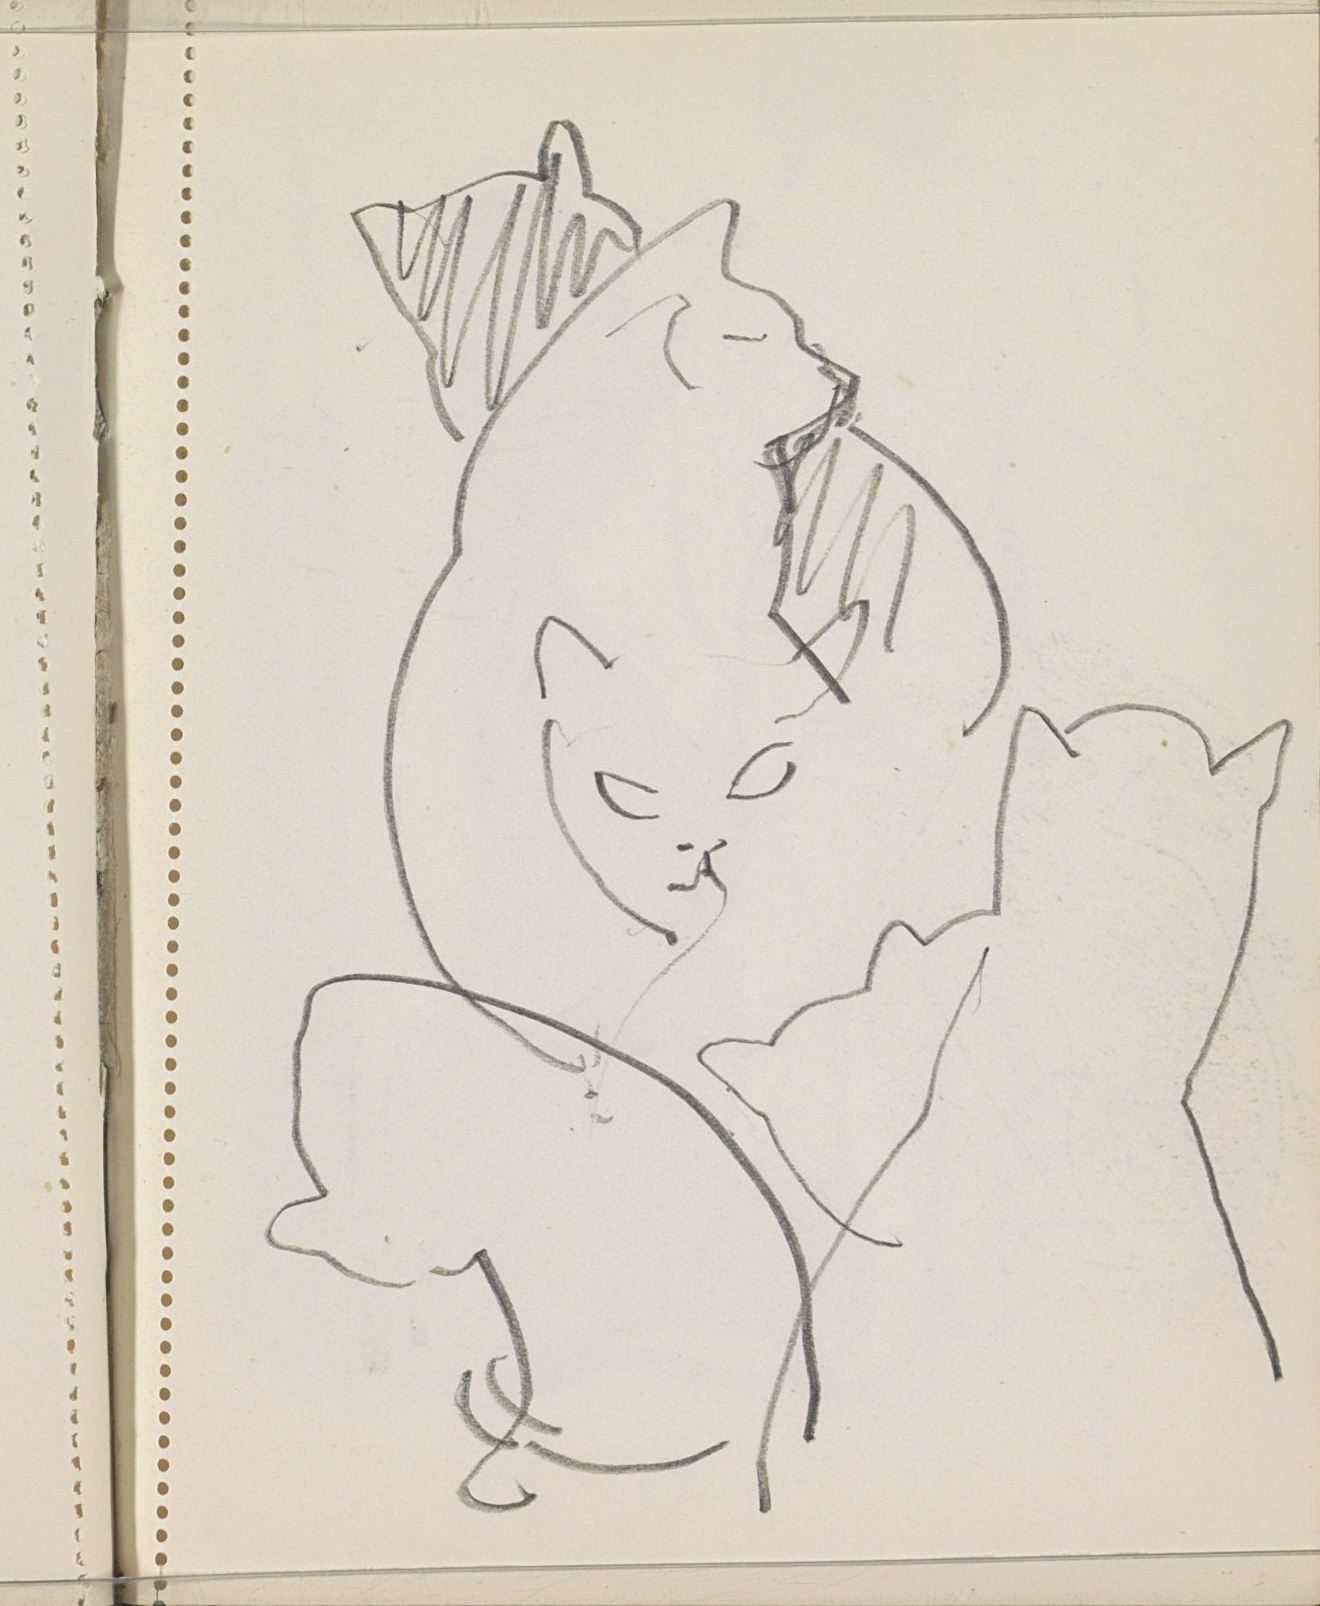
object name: sketchbook leaf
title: Katten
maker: reijer stolk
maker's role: draughtsman, print maker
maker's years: 1896-1945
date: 1906-1945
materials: paper, pencil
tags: cat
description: Blad 26 recto uit een schetsboek met 42 bladen.